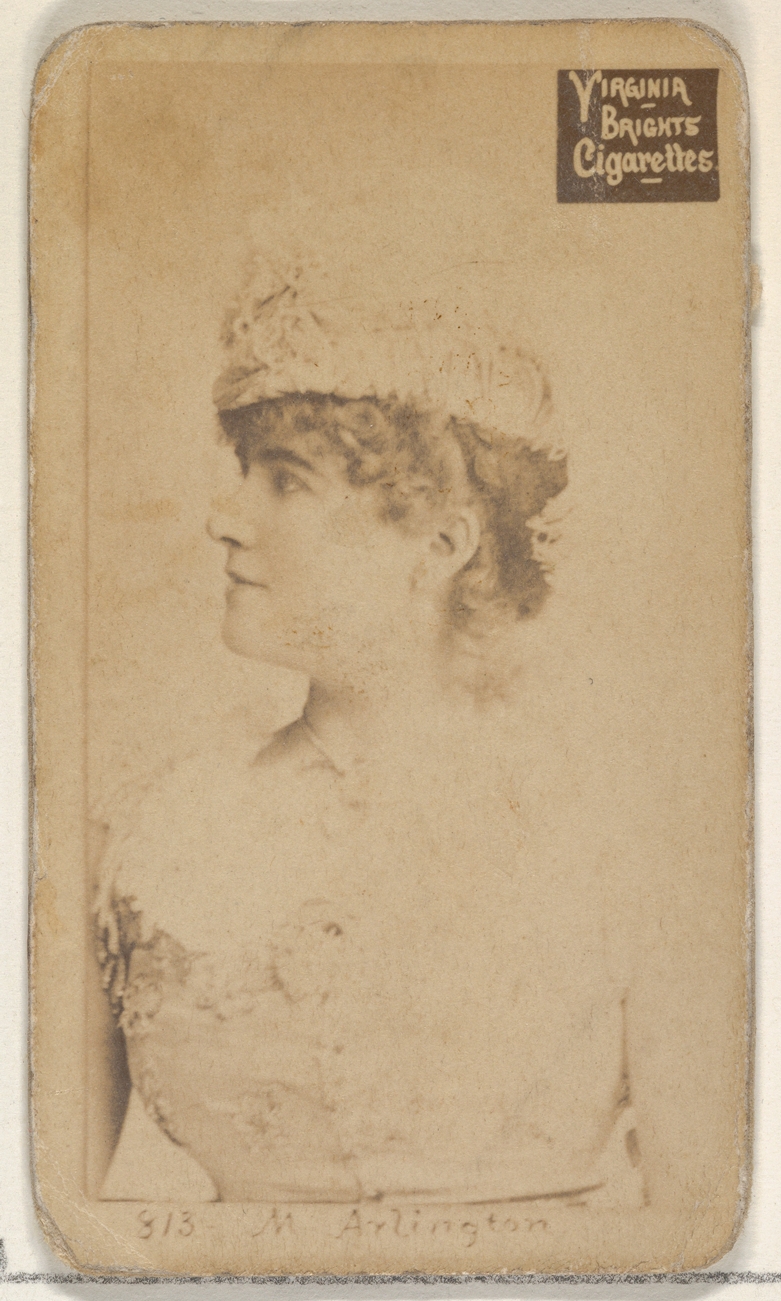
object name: photograph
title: Card 813, Maggie Arlington, from the Actors and Actresses series (N45, Type 2) for Virginia Brights Cigarettes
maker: allen & ginter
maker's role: publisher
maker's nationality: american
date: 1888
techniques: albumen silver print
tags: women,actresses